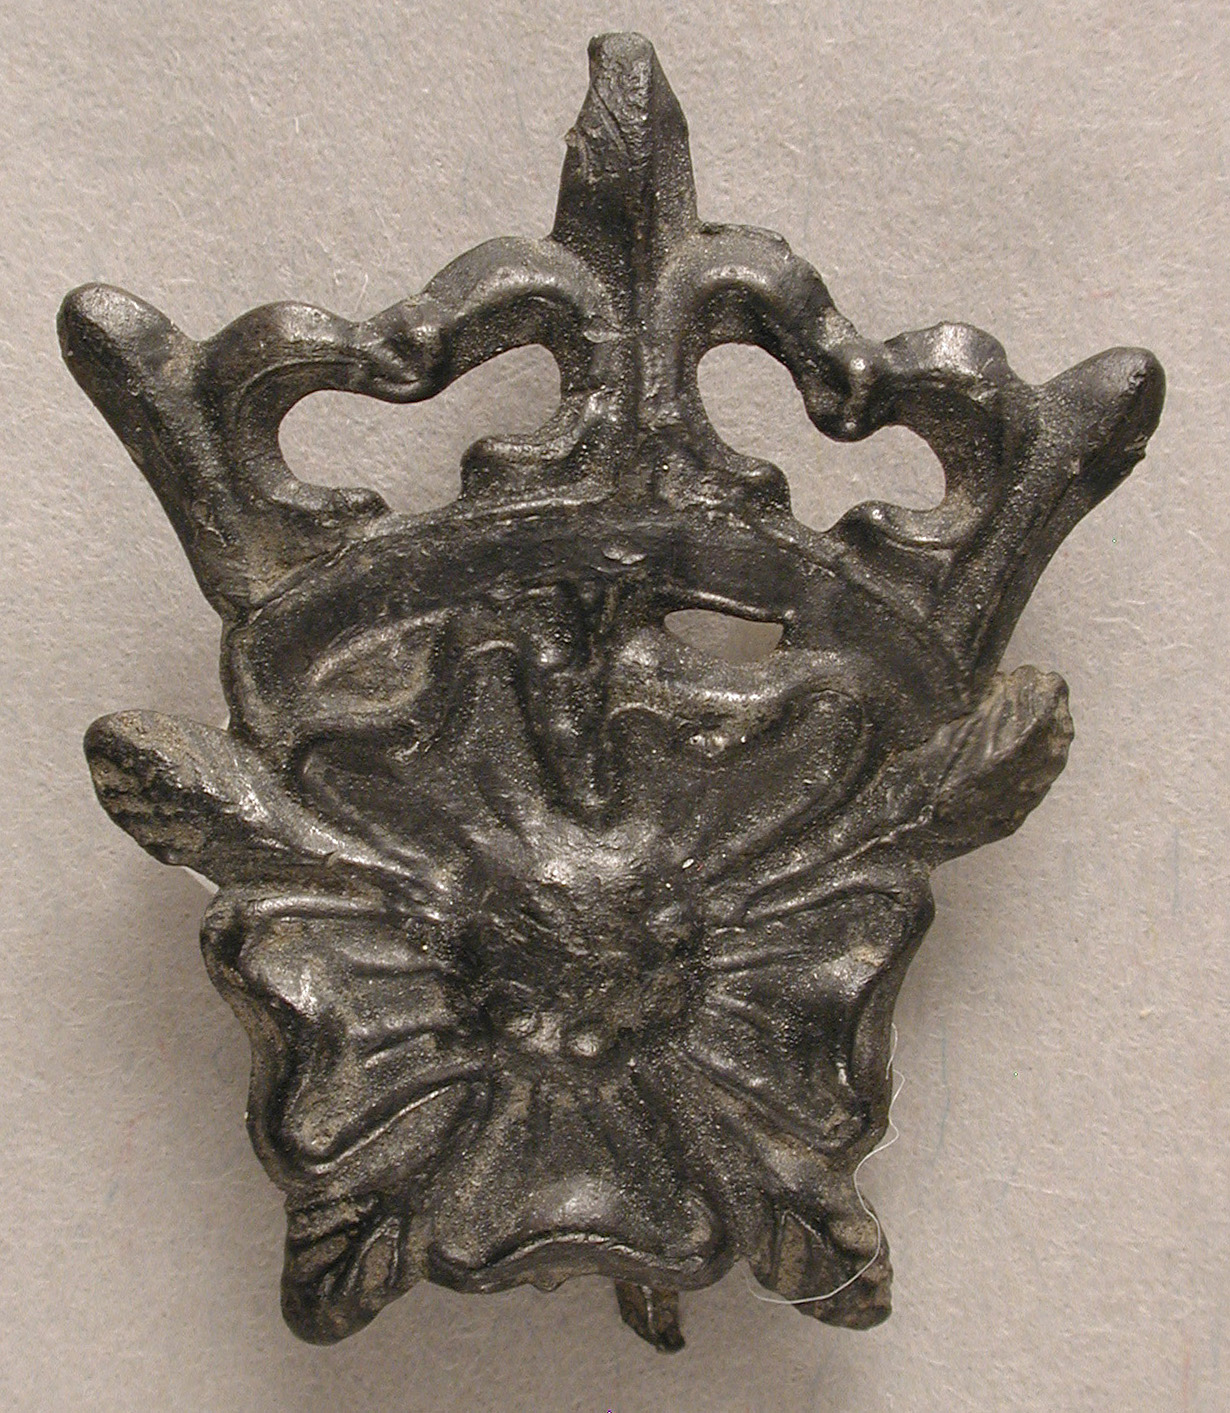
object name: pilgrim's badge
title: Badge with Tudor Rose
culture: british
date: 1401-1500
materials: alloy, lead, tin